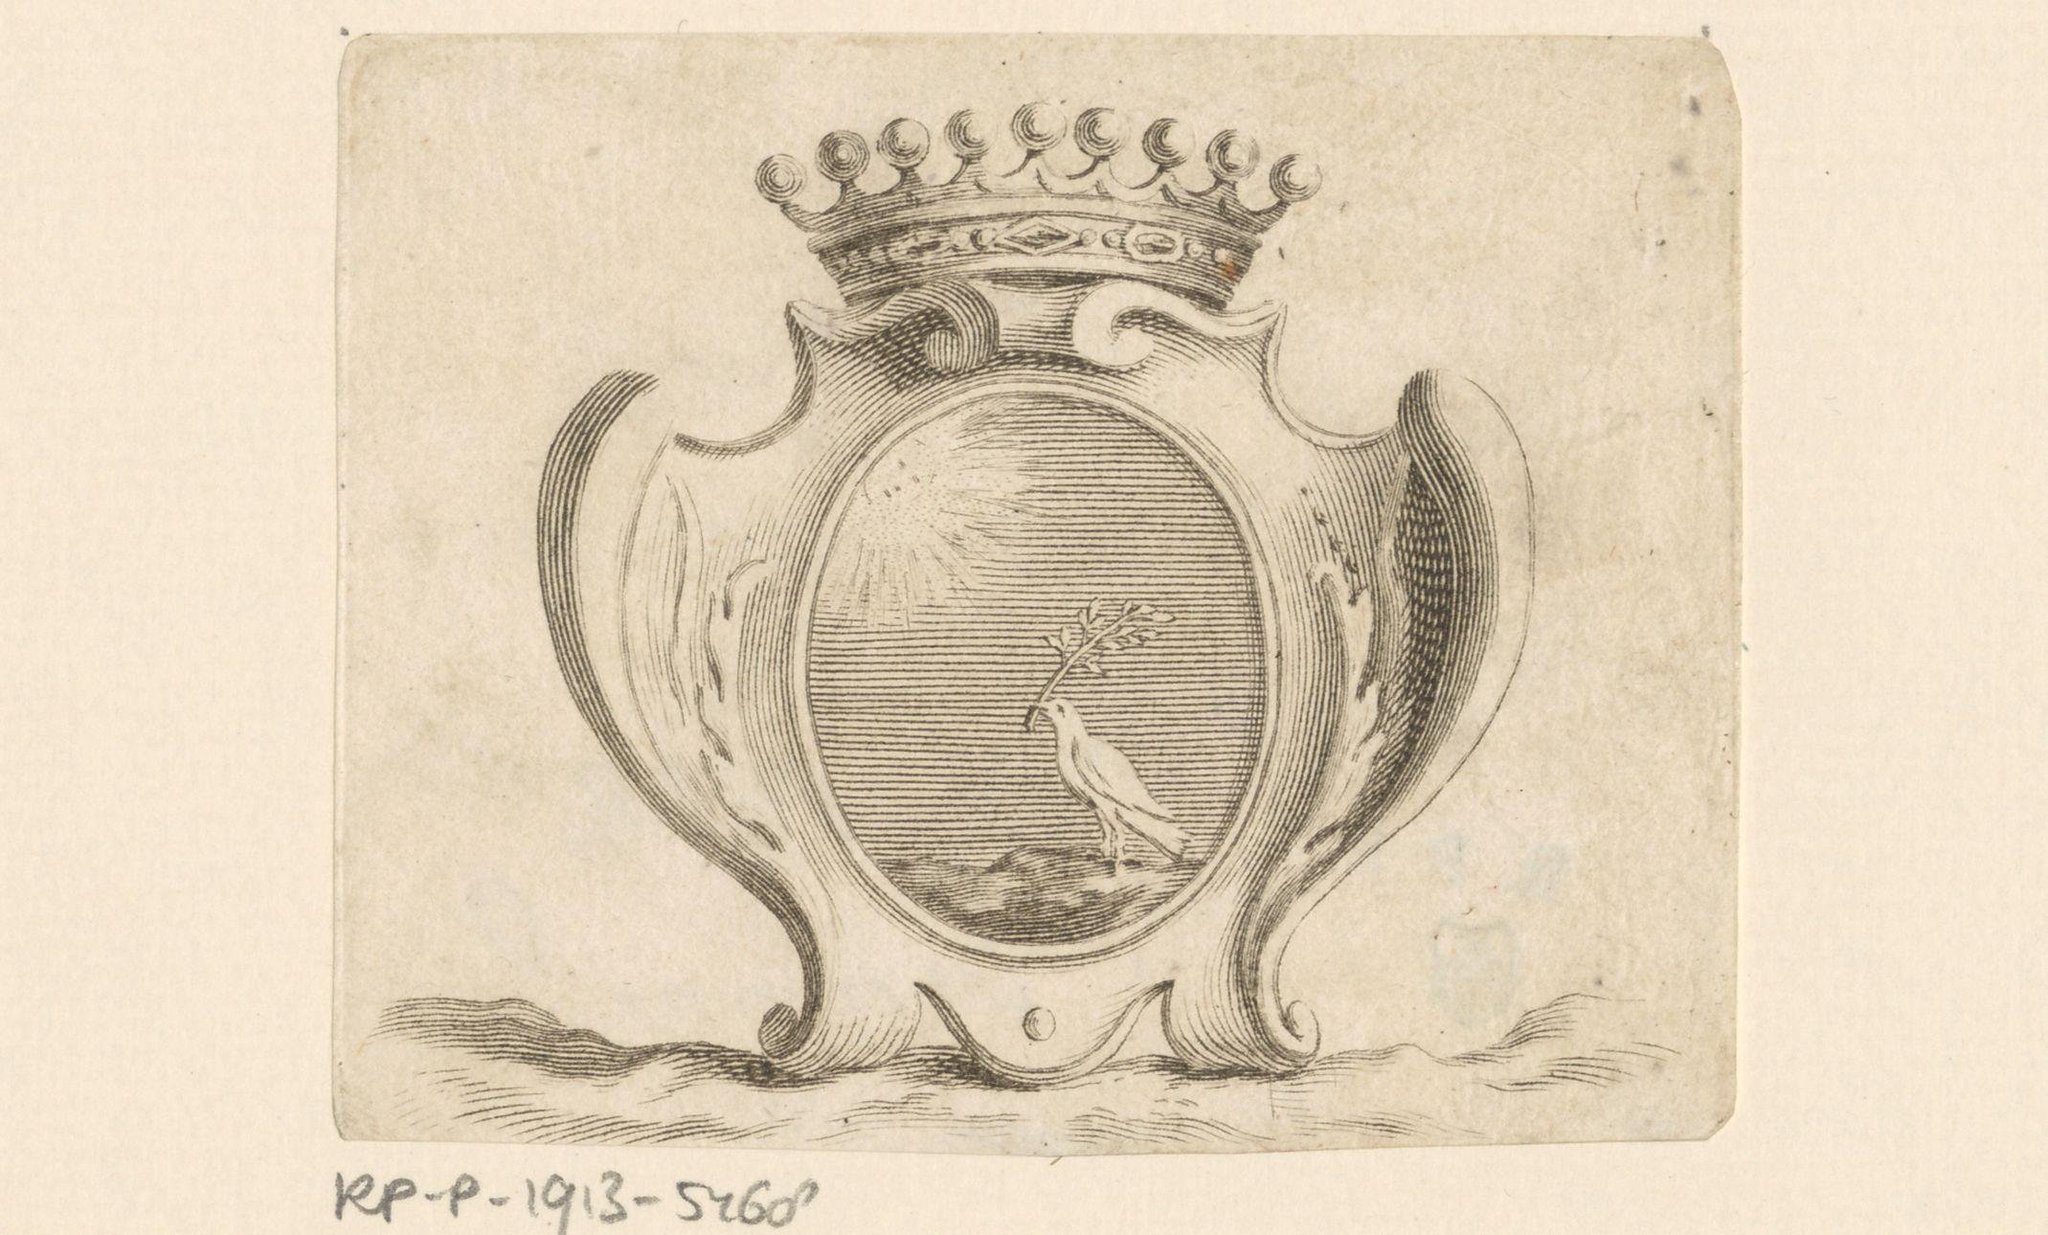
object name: bookplate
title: Ex libris van Estienne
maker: Anonymous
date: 1700-1849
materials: paper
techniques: engraving, etching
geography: france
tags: pigeon (as messenger), sun represented as face, wheel, etc., armorial bearing, heraldry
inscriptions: collector's mark: Lugt 2760, collector's mark: Lugt 2233